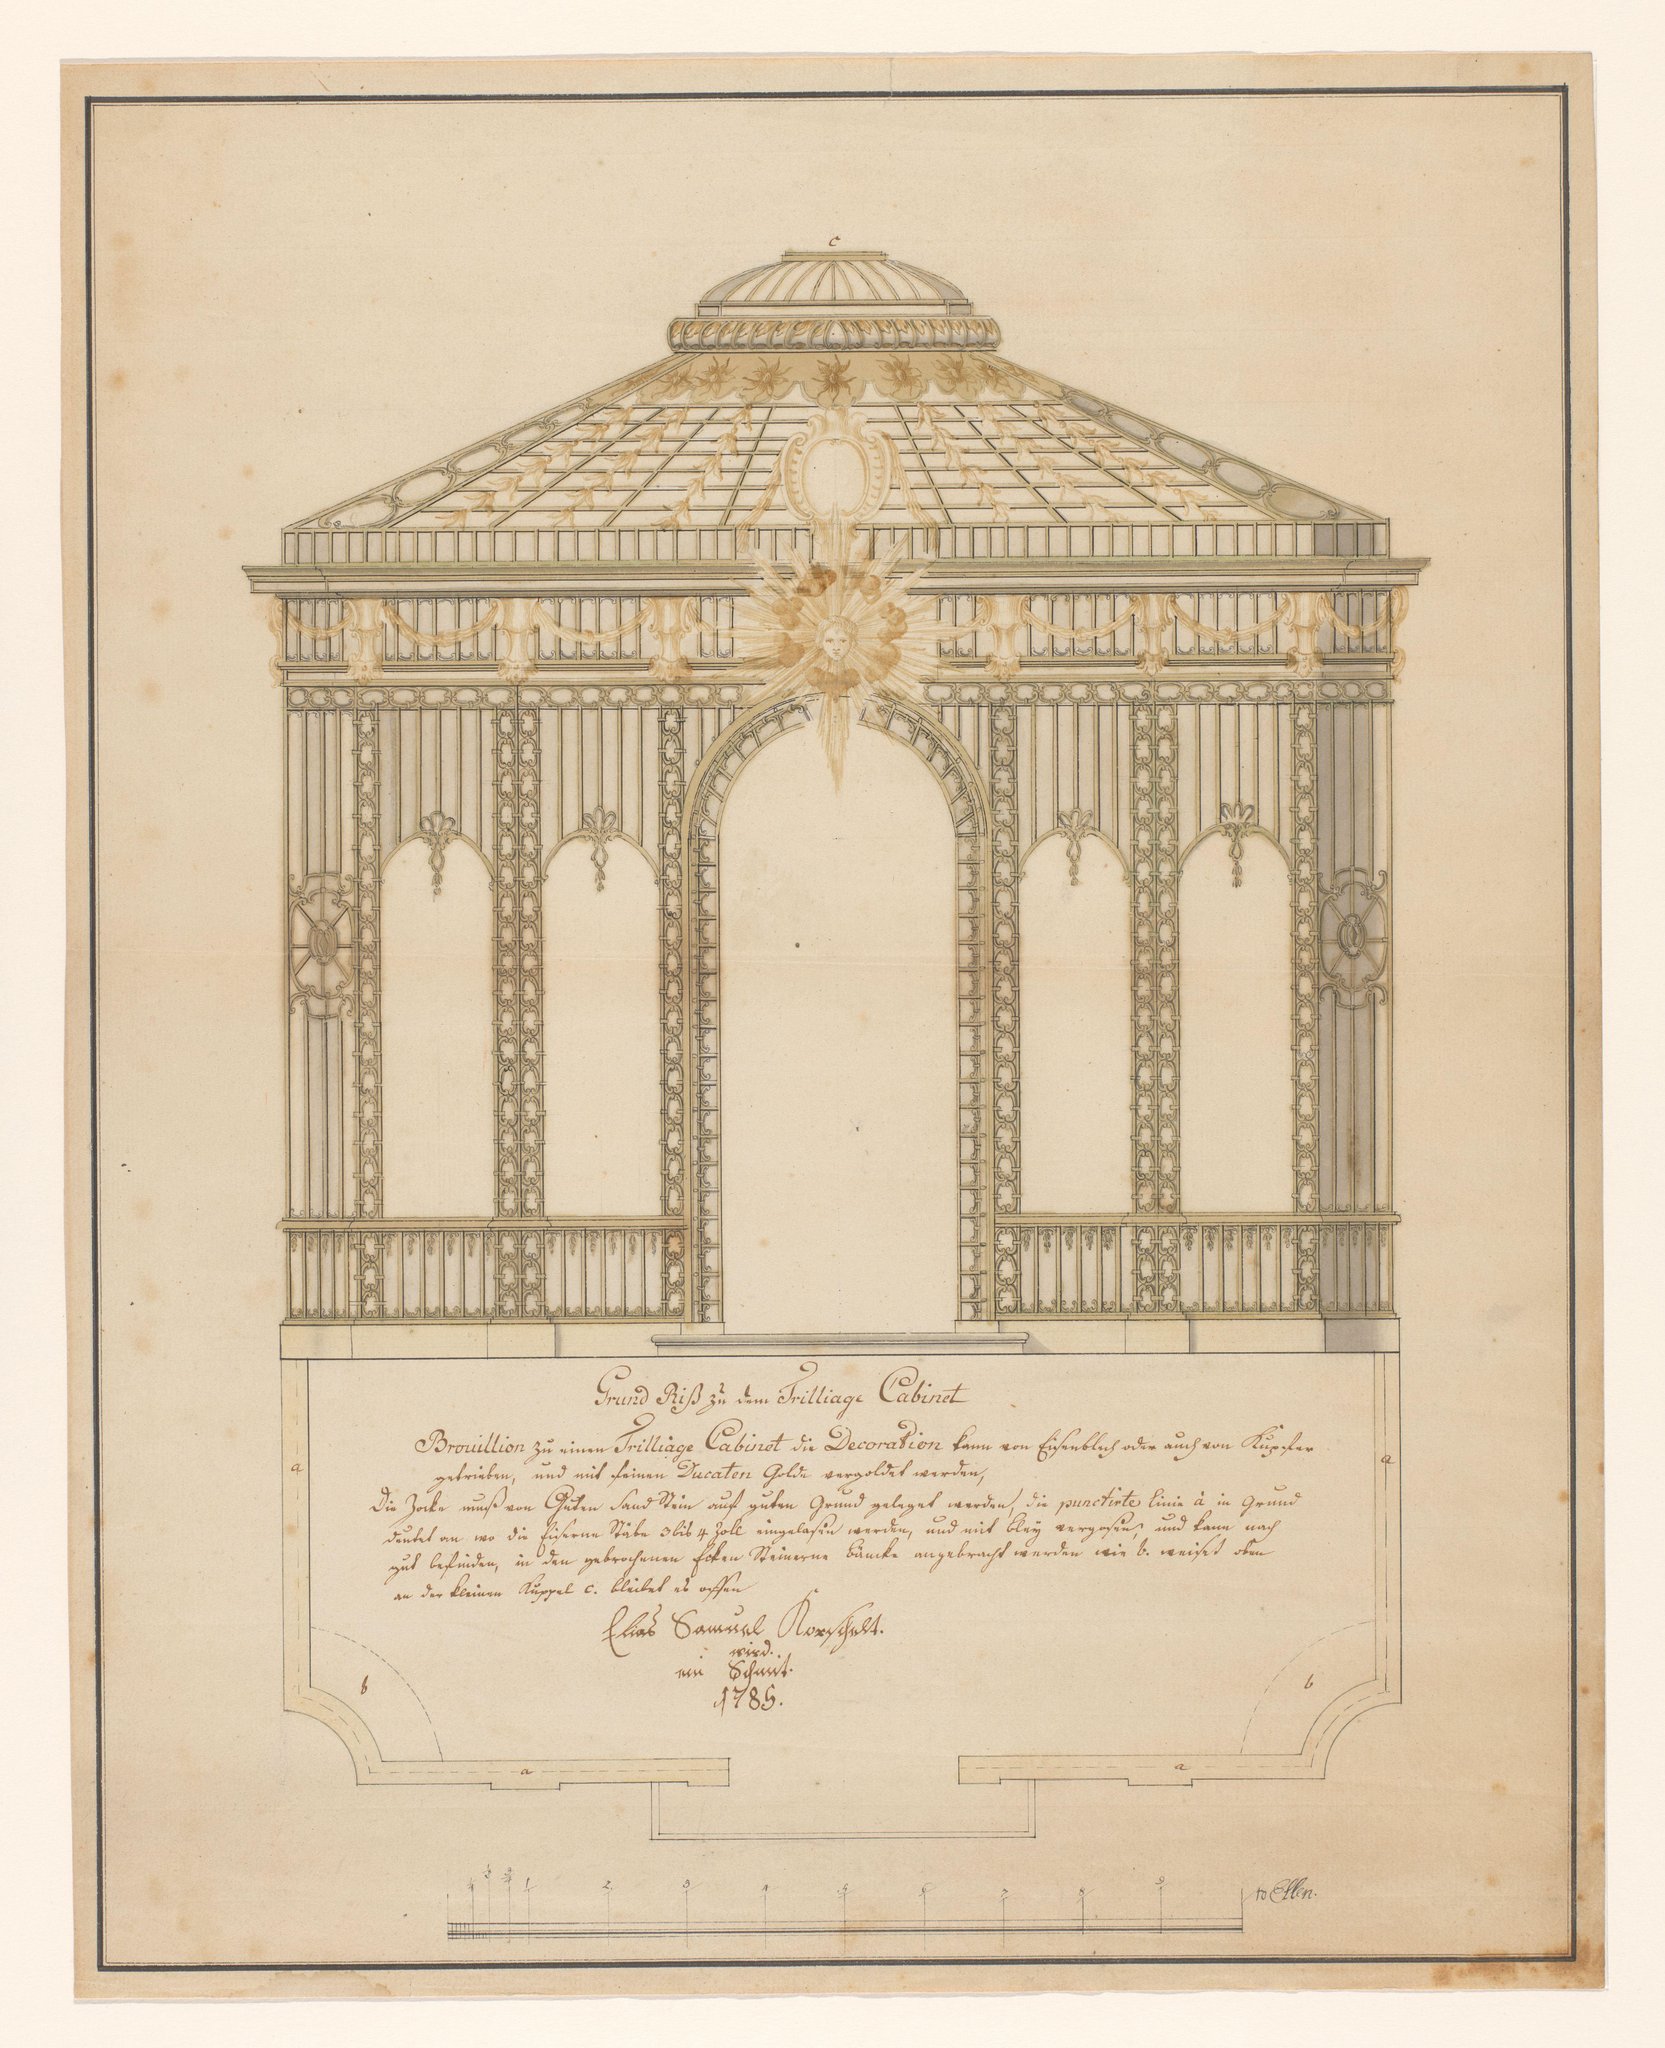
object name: drawing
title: Ontwerp voor een tuinpaviljoen van gedeeltelijk verguld smeedwerk, met eronder een plattegrond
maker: elias samuel korschelt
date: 1785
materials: graphite, ink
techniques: drawing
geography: germany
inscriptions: watermark: ‘J HONIG / & / ZOONEN’, inscription: ‘c.’, mark: ‘Contramerk: wapen met dubbele balk (Strasburg bend) met daarboven een lelie, daaronder een bijenkorf en JH&Z.’, inscription: ‘Grund Riss zu dem Trilliage Cabinet / Brouillion zu einem Trilliage Cabinet die Decoration kann von Eisenblech oder auch von Kupfer / getrieben, und mit feinem Ducaten Gold vergoldet werden, / Die Zocke muss von Guten Sandstein auf guten Grund geleget werden, die punctirte linie à in Grund / deutet an wo die eisernen Stäbe 3 bis 4 zoll eingelassen werden, und mit bleij vergossen, und kann noch / gut befinden, in den gebrochenen Ecken steinerne bäncke angebracht werden win b. waiset oben / an der kleinen Kuppel c. bleibet es offen / Elias Samuel Korschelt / wird. / ein Schmit. / 1785. a b a a b a’, size: ‘Maatverdeling met: ¼ ½ ¾ 1 2 3 4 5 6 7 8 9 10 Ellen.’